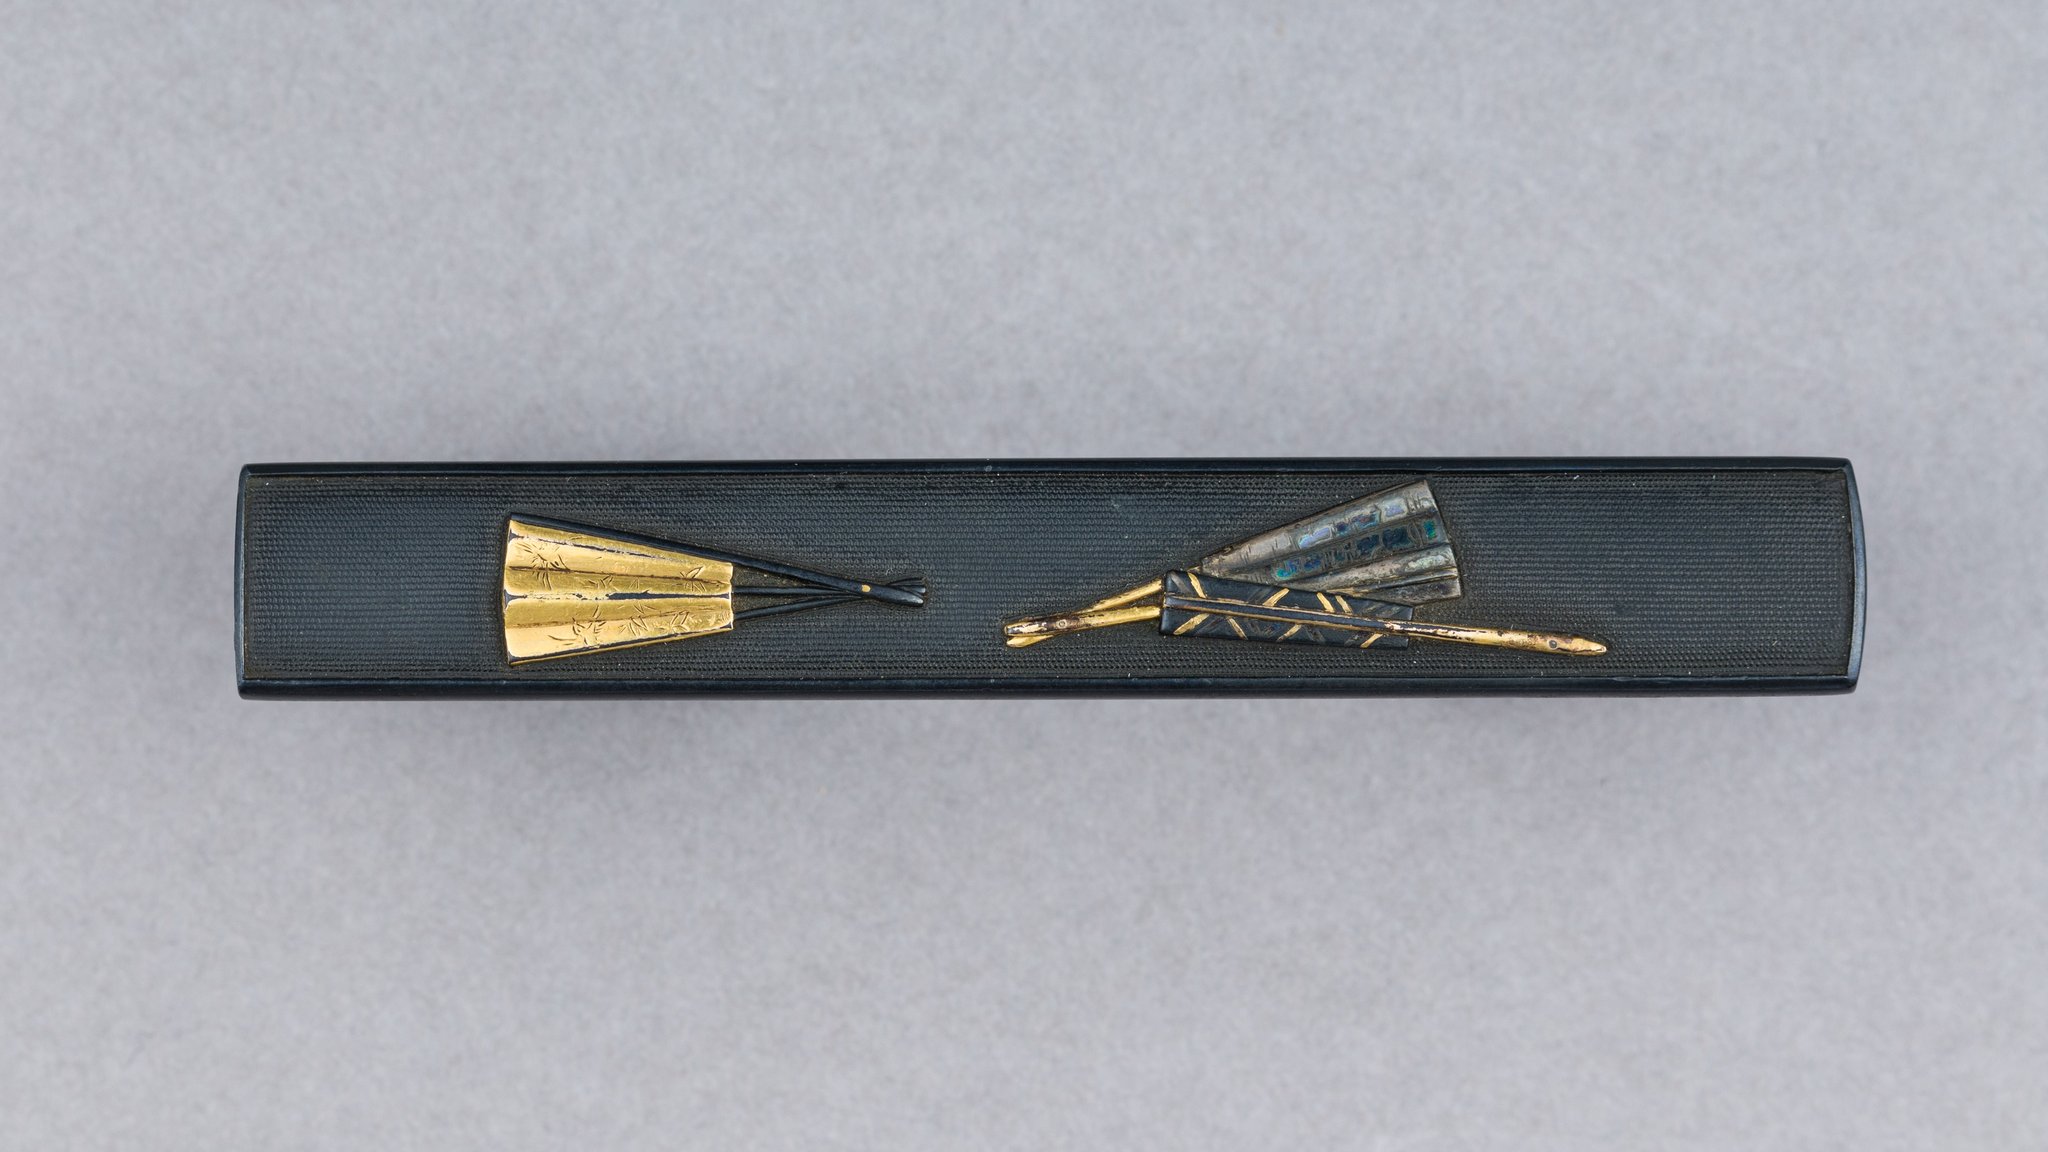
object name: knife handle kozuka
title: Knife Handle (Kozuka)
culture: japanese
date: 1601-1700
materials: gold alloy, gold, silver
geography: japan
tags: fans